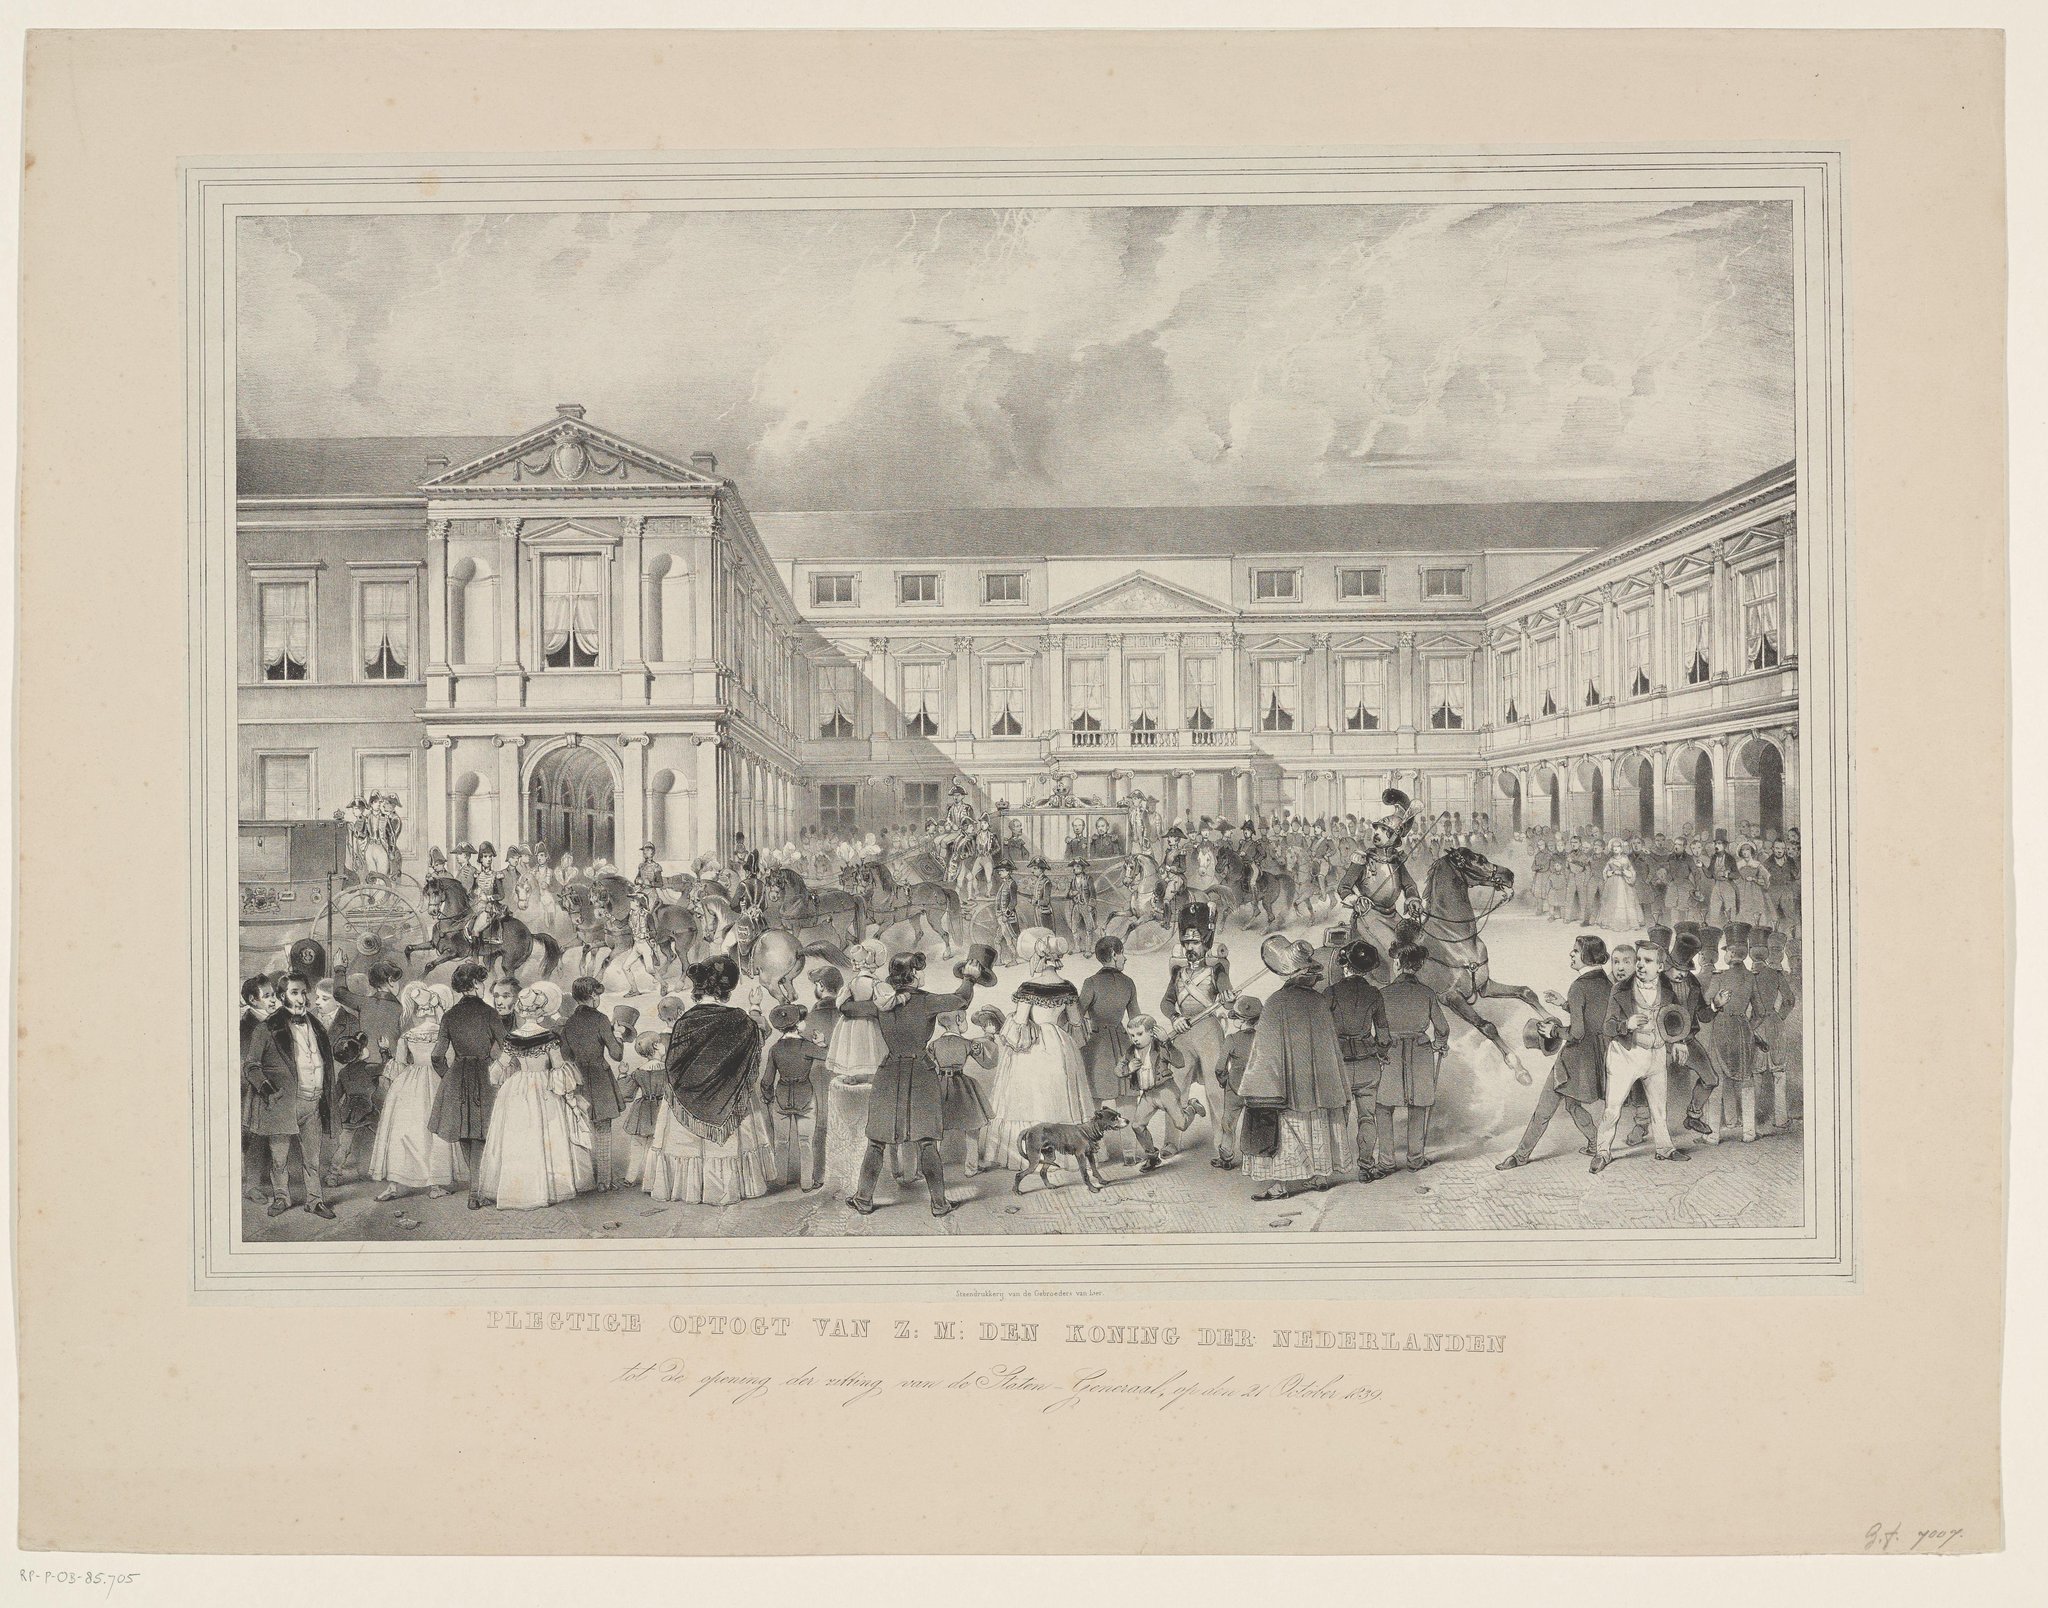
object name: print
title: Plegtige Optogt van Z:M: den Koning der Nederlanden tot de opening der zitting van de Staten-Generaal, op den 21 October 1839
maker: Anonymous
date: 1839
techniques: printmaking, lithograph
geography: netherlands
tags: the hague, berlin, william i of the netherlands, william ii of the netherlands, frederik (prins der nederlanden), four-wheeled vehicle drawn by more than three animals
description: Vertrek van de koets met koning Willem I en zijn twee zoons met escorte vanaf Paleis Noordeinde voor de opening van de zitting van de Staten-Generaal in Den Haag, 21 oktober 1839.